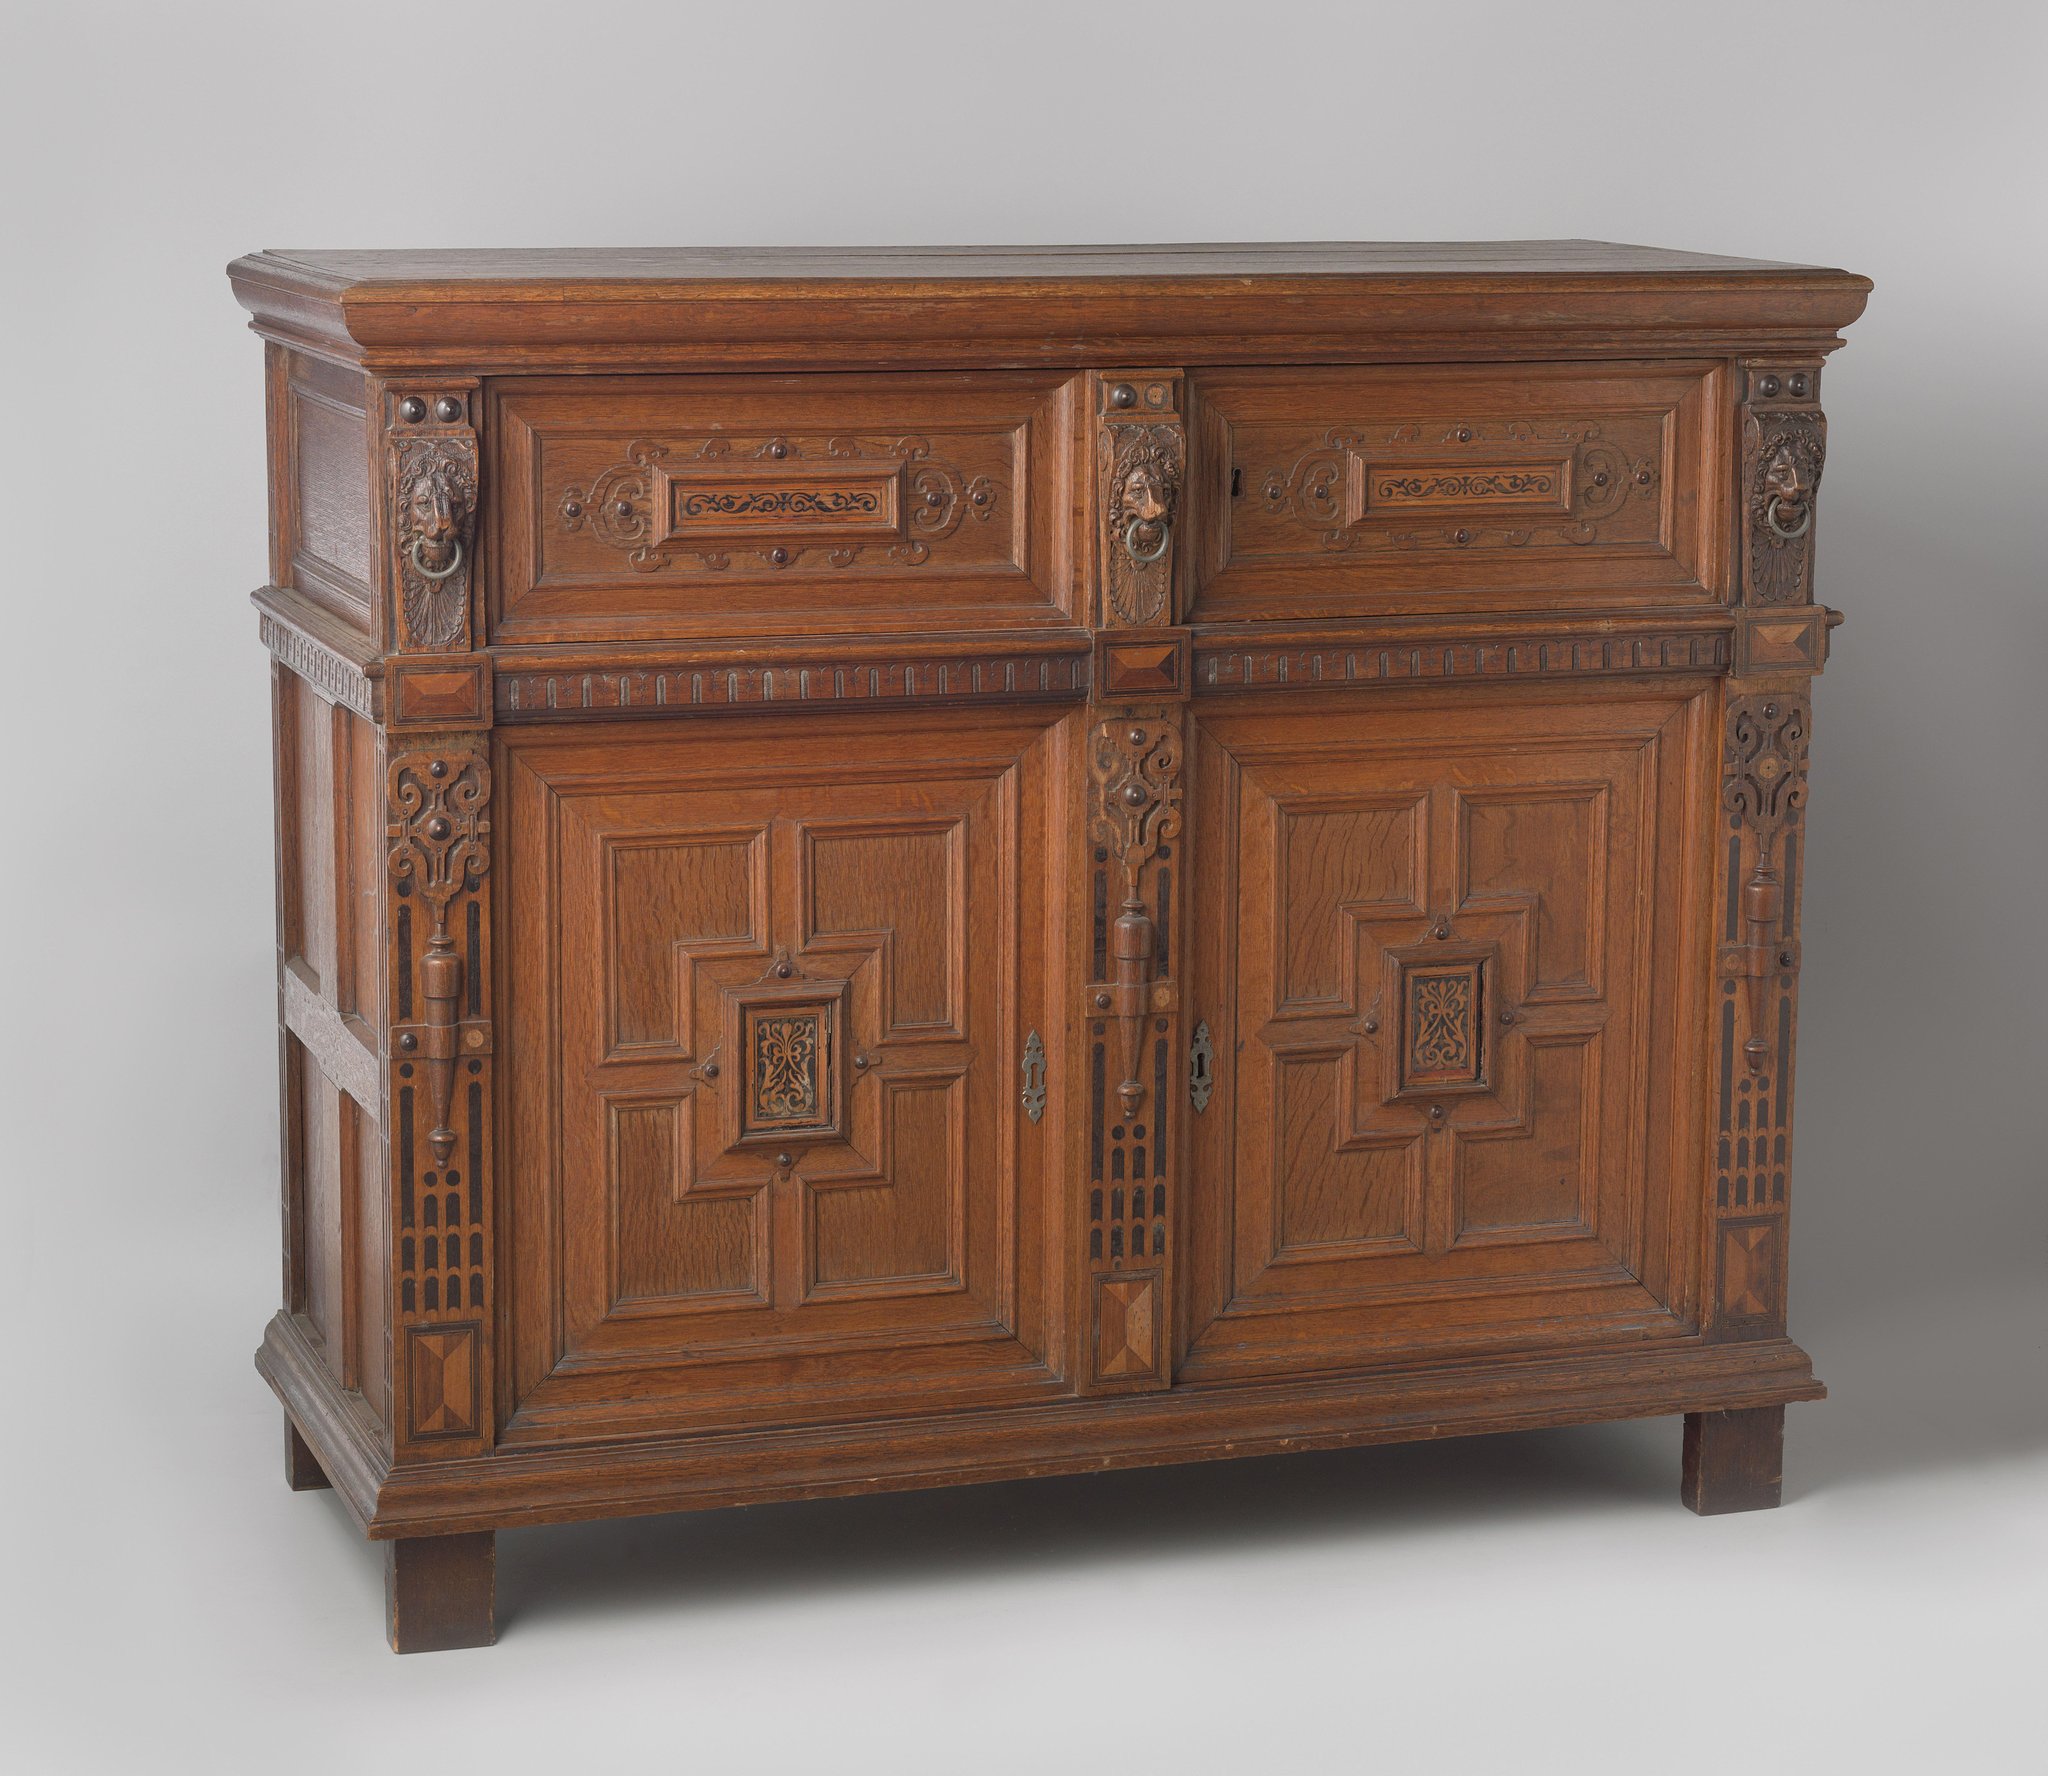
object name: furniture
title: Zeeuwse kast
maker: Anonymous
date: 1650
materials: wood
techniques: cutting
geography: zeeland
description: Zeeuwse kast van eike-, ebbe-, palm- en palissanderhout. De bovenkast heeft twee deuren met panelen met cartouches en grotesken, tussen drie leeuwenkoppen met ring. De middenregel bestaat uit blokken met inlegwerk tussen diamantkoppen. De deuren van de hogere onderkast dragen cornispanelen. De midden- en hoekstijlen vertonen ieder een gesphanger, druiper, cannelurebiezen, diamantkop en inlegwerk. Zijkanten met gecorniste bovenpanelen en onderpanelen met brede lijsten en gebiljoneerde dorpels.